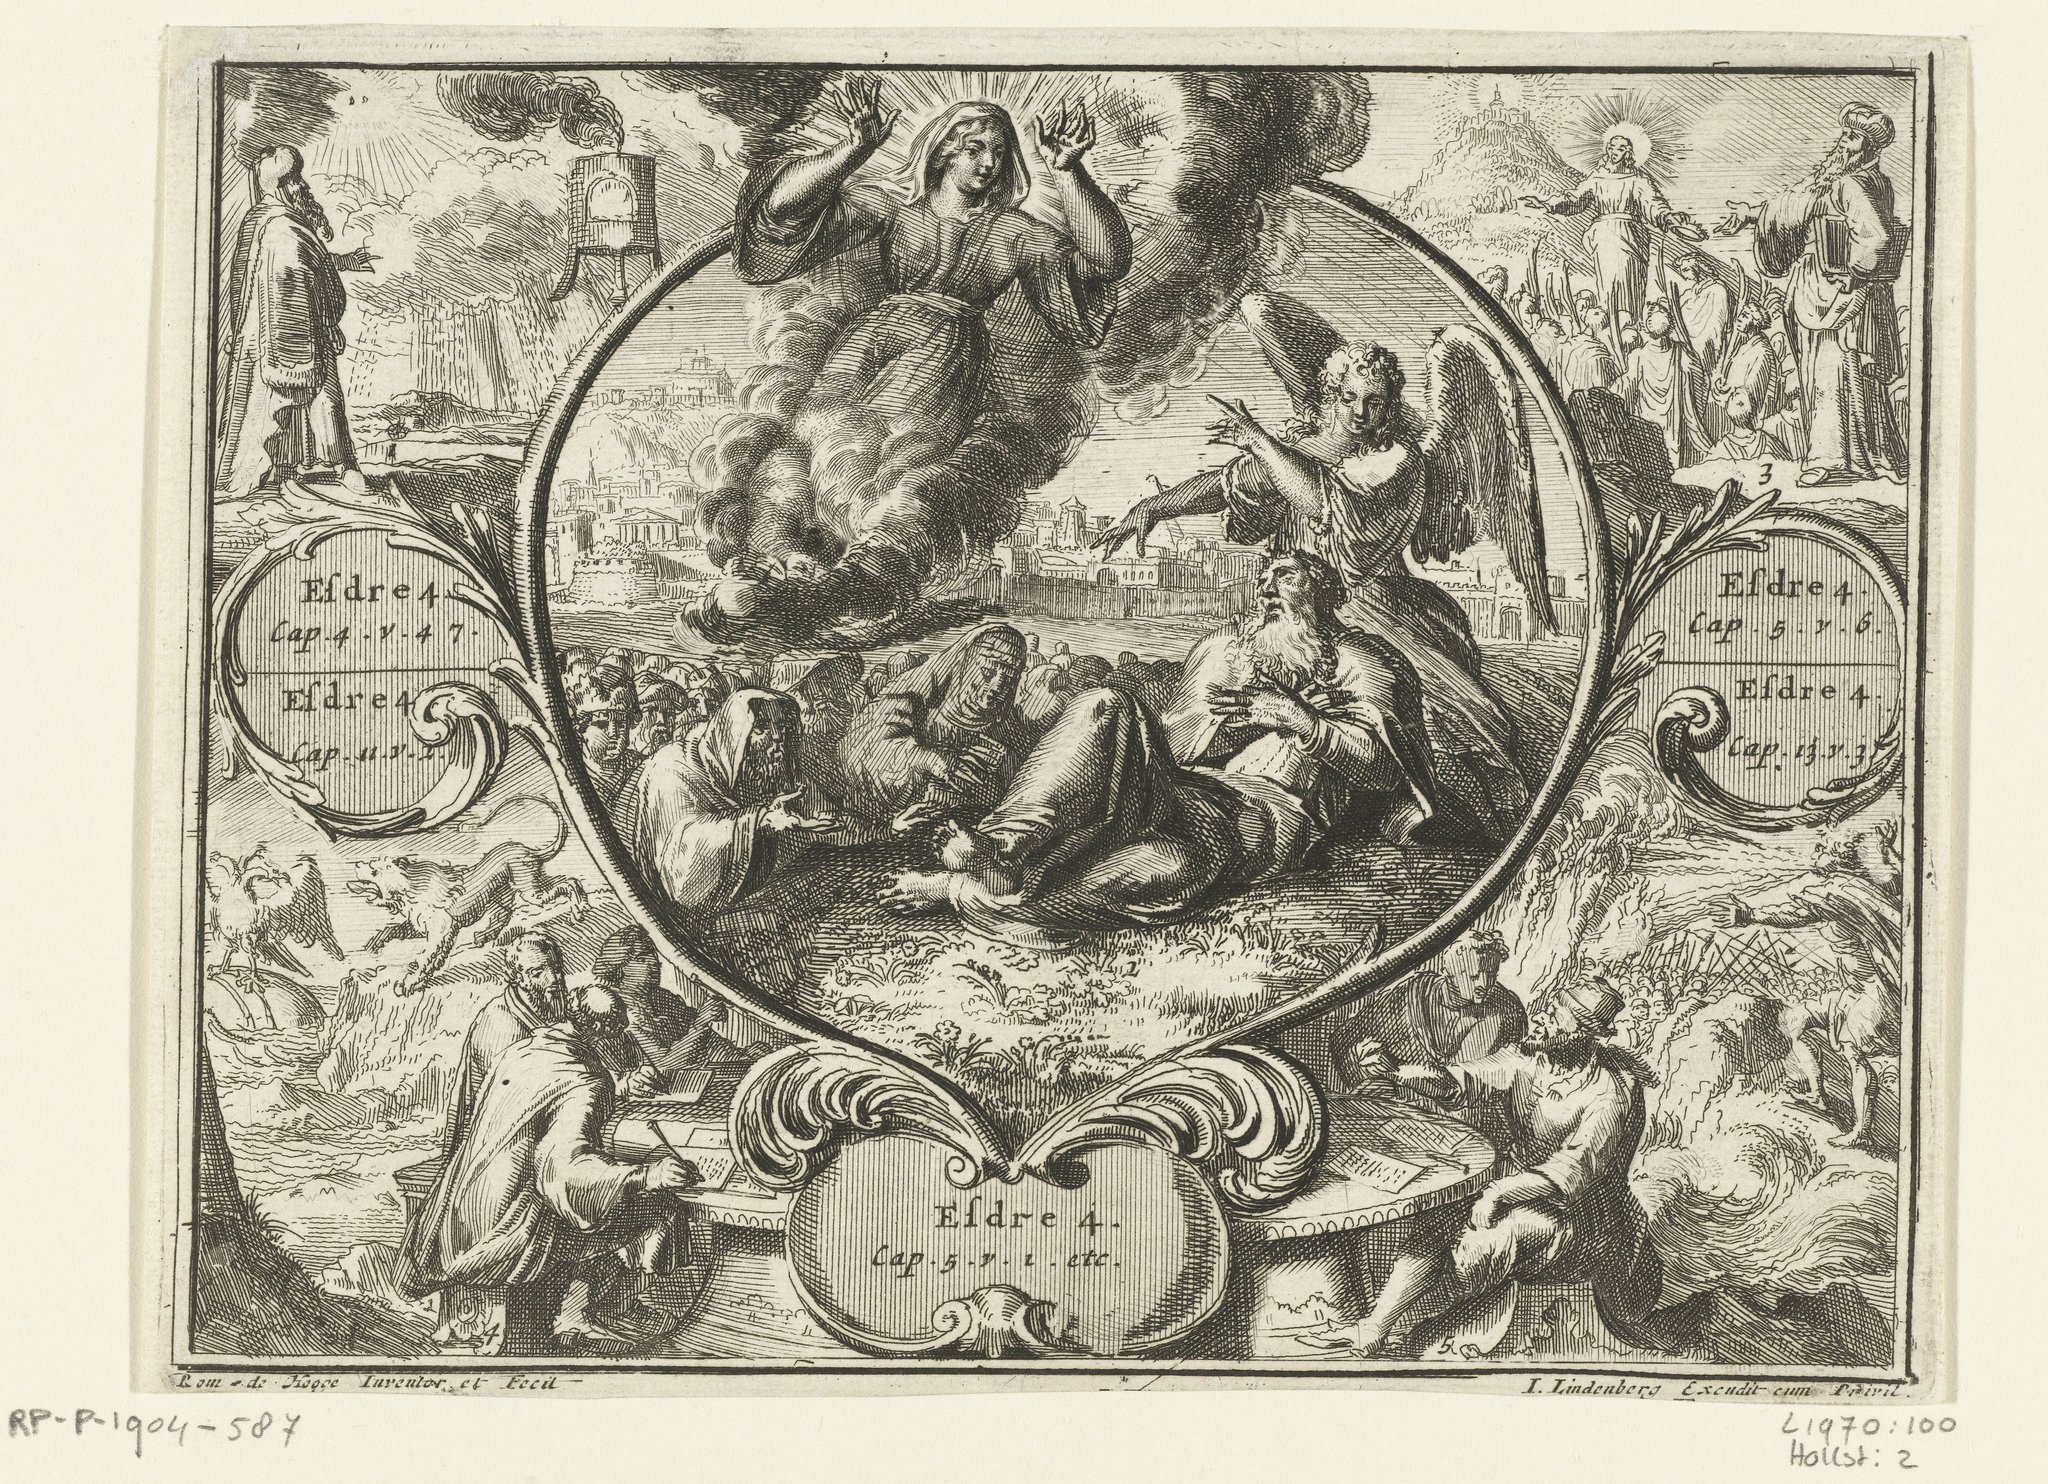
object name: print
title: Ezra, engel en verschijning van een vrouw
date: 1705-1715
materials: paper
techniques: engraving, etching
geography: amsterdam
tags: ezra's vision of the eagle and the lion (2 esdras 11-12), ezra and the archangel uriel (2 esdras 4:1)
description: Illustratie voor: J. Basnage, 't Groot waerelds tafereel, waar in de heilige en waereldsche geschiedenissen en veranderingen zedert de schepping des waerelds tot het uiteinde van de Openbaring van Joannes, worden afgemaalt, Amsterdam 1715, fol. 3 (aanvulling bij Henricus Vos, Alle de voornaamste historien des Ouden en Nieuwen Testaments. Verbeeld in uytsteekende konst-platen, 2 delen, Amsterdam)